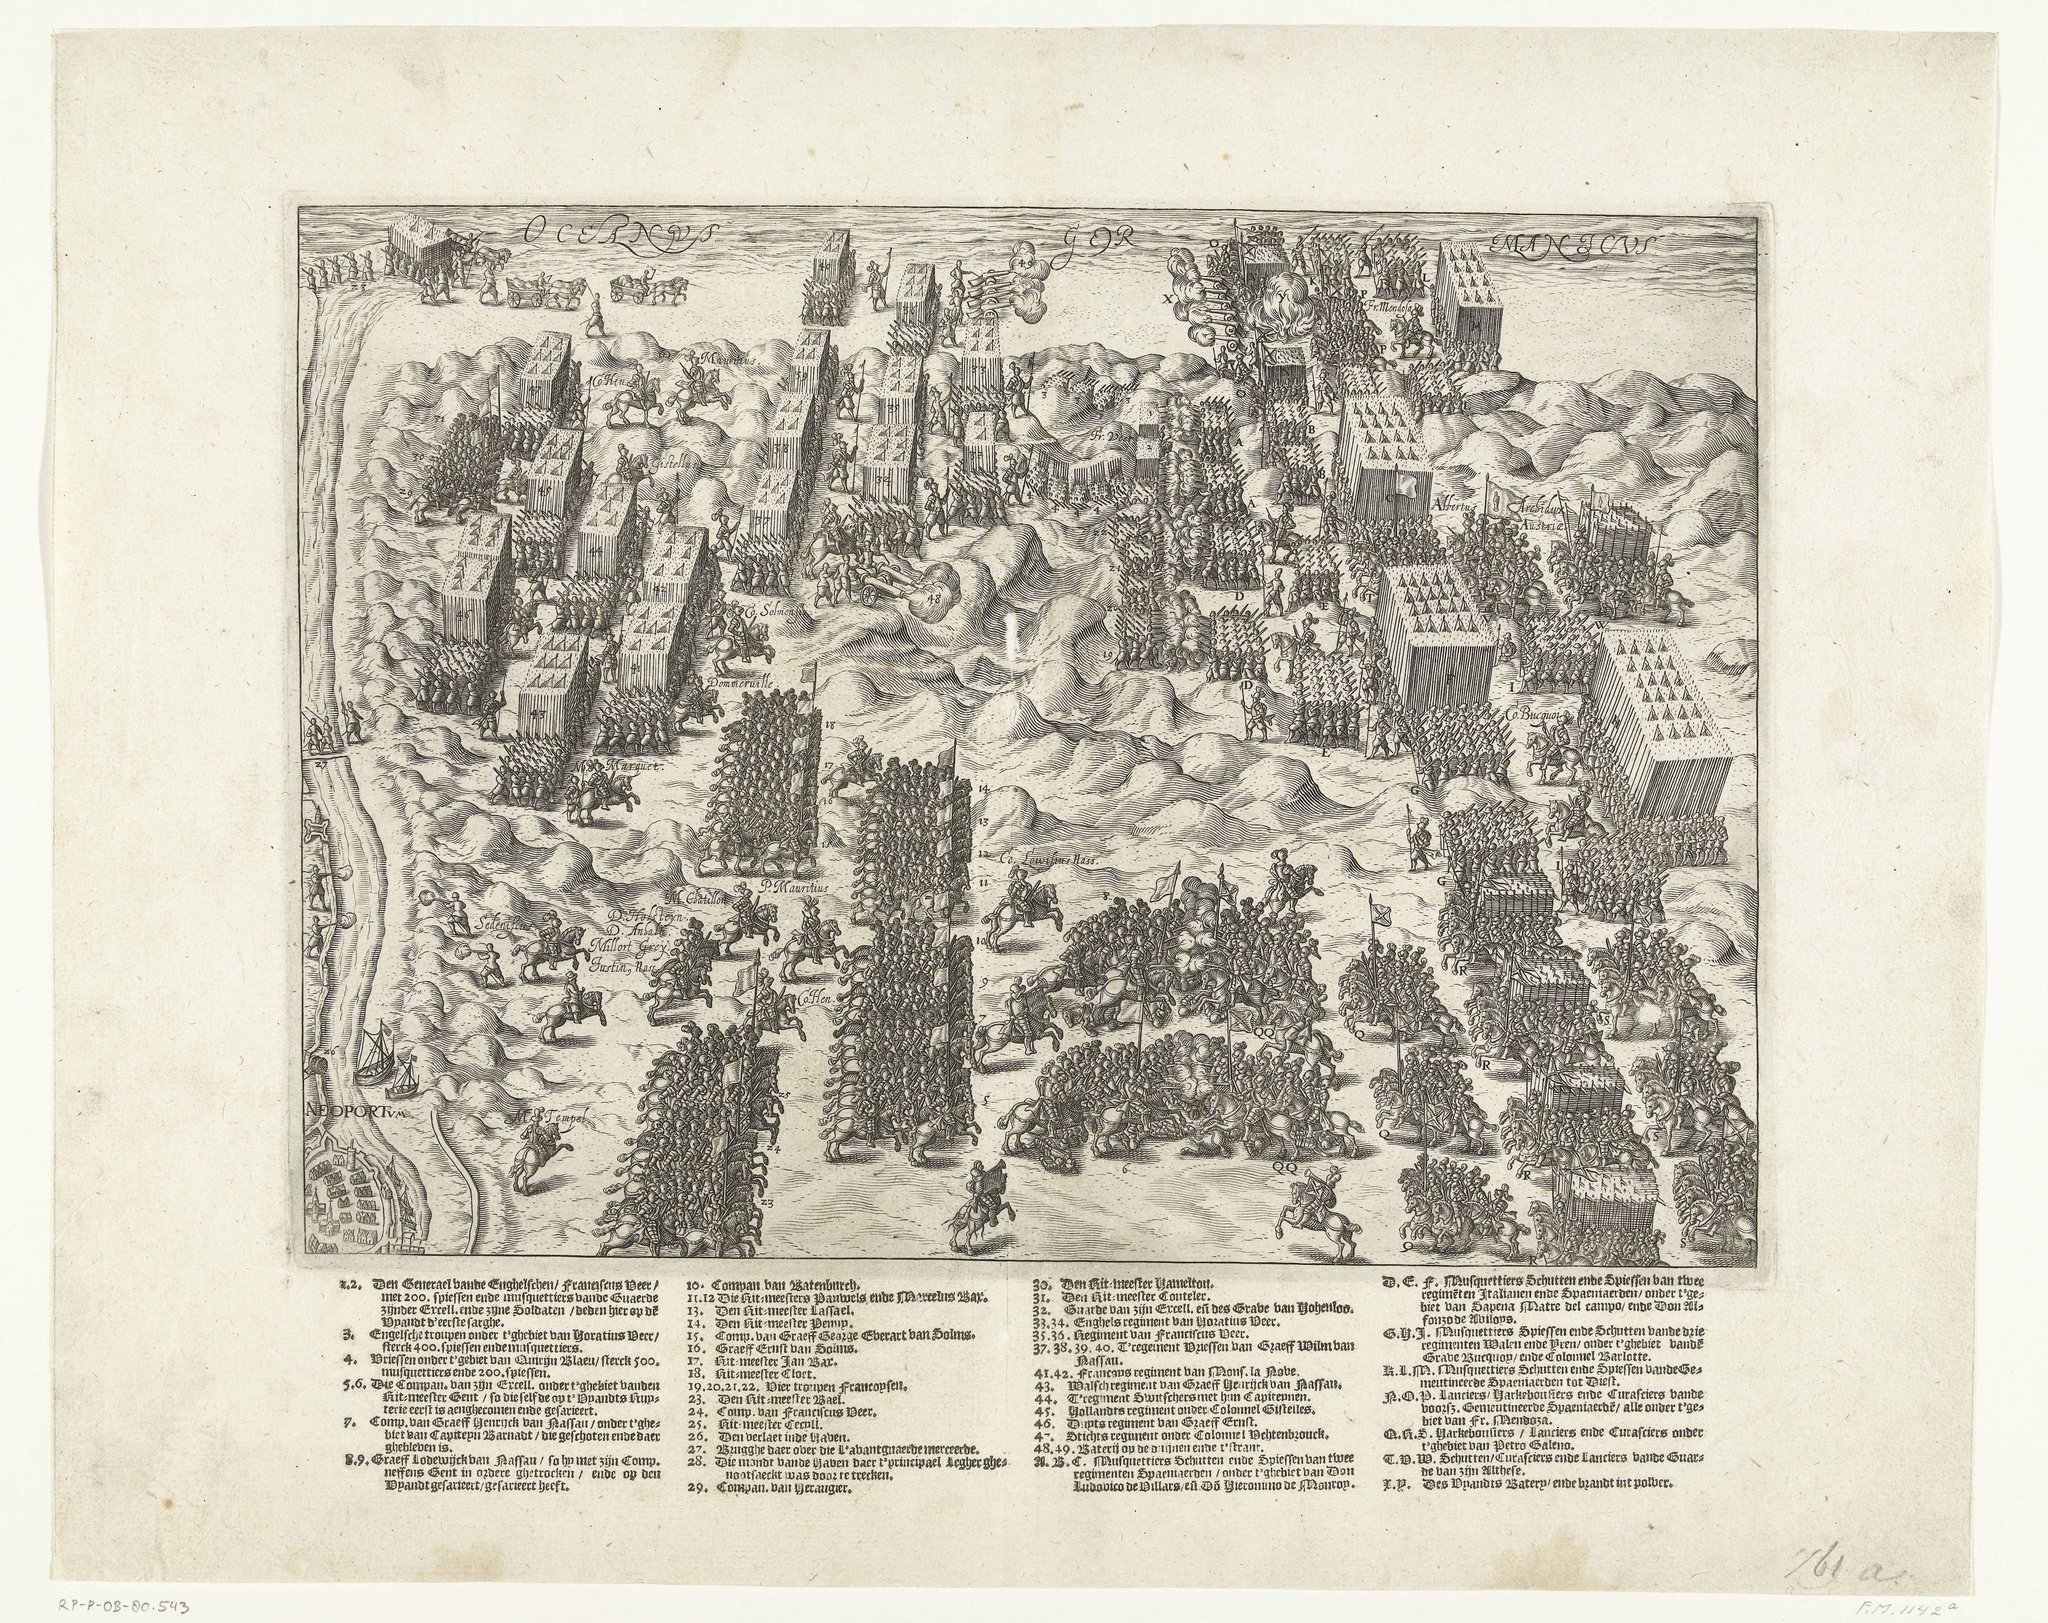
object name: print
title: Slag bij Nieuwpoort, 1600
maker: bartholomeus willemsz. dolendo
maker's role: print maker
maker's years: 1560-1626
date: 1600-1601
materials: paper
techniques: engraving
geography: northern netherlands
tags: the hague, maurice (prince of orange), brussels, albrecht aartshertog van oostenrijk, battle (+ land forces), battle of nieuwpoort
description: Gebruikt als illustratie in: J.J. Orlers, Den Nassauschen Lauren-Crans: Beschrijvinghe ende af-beeldinge van alle de victorien ... die Godt Almachtich de ... Staten der Vereenichde Nederlanden verleent heeft, deur het wijs ende clouck beleyt des Hooch-ghebooren Fursts Maurits van Nassau, J.J. Orlers en H. van Haestens, Leiden 1610, fol. 152/153. Vrij naar de grote prent van Floris Balthasarsz. van Berckenrode (FMH 1136).